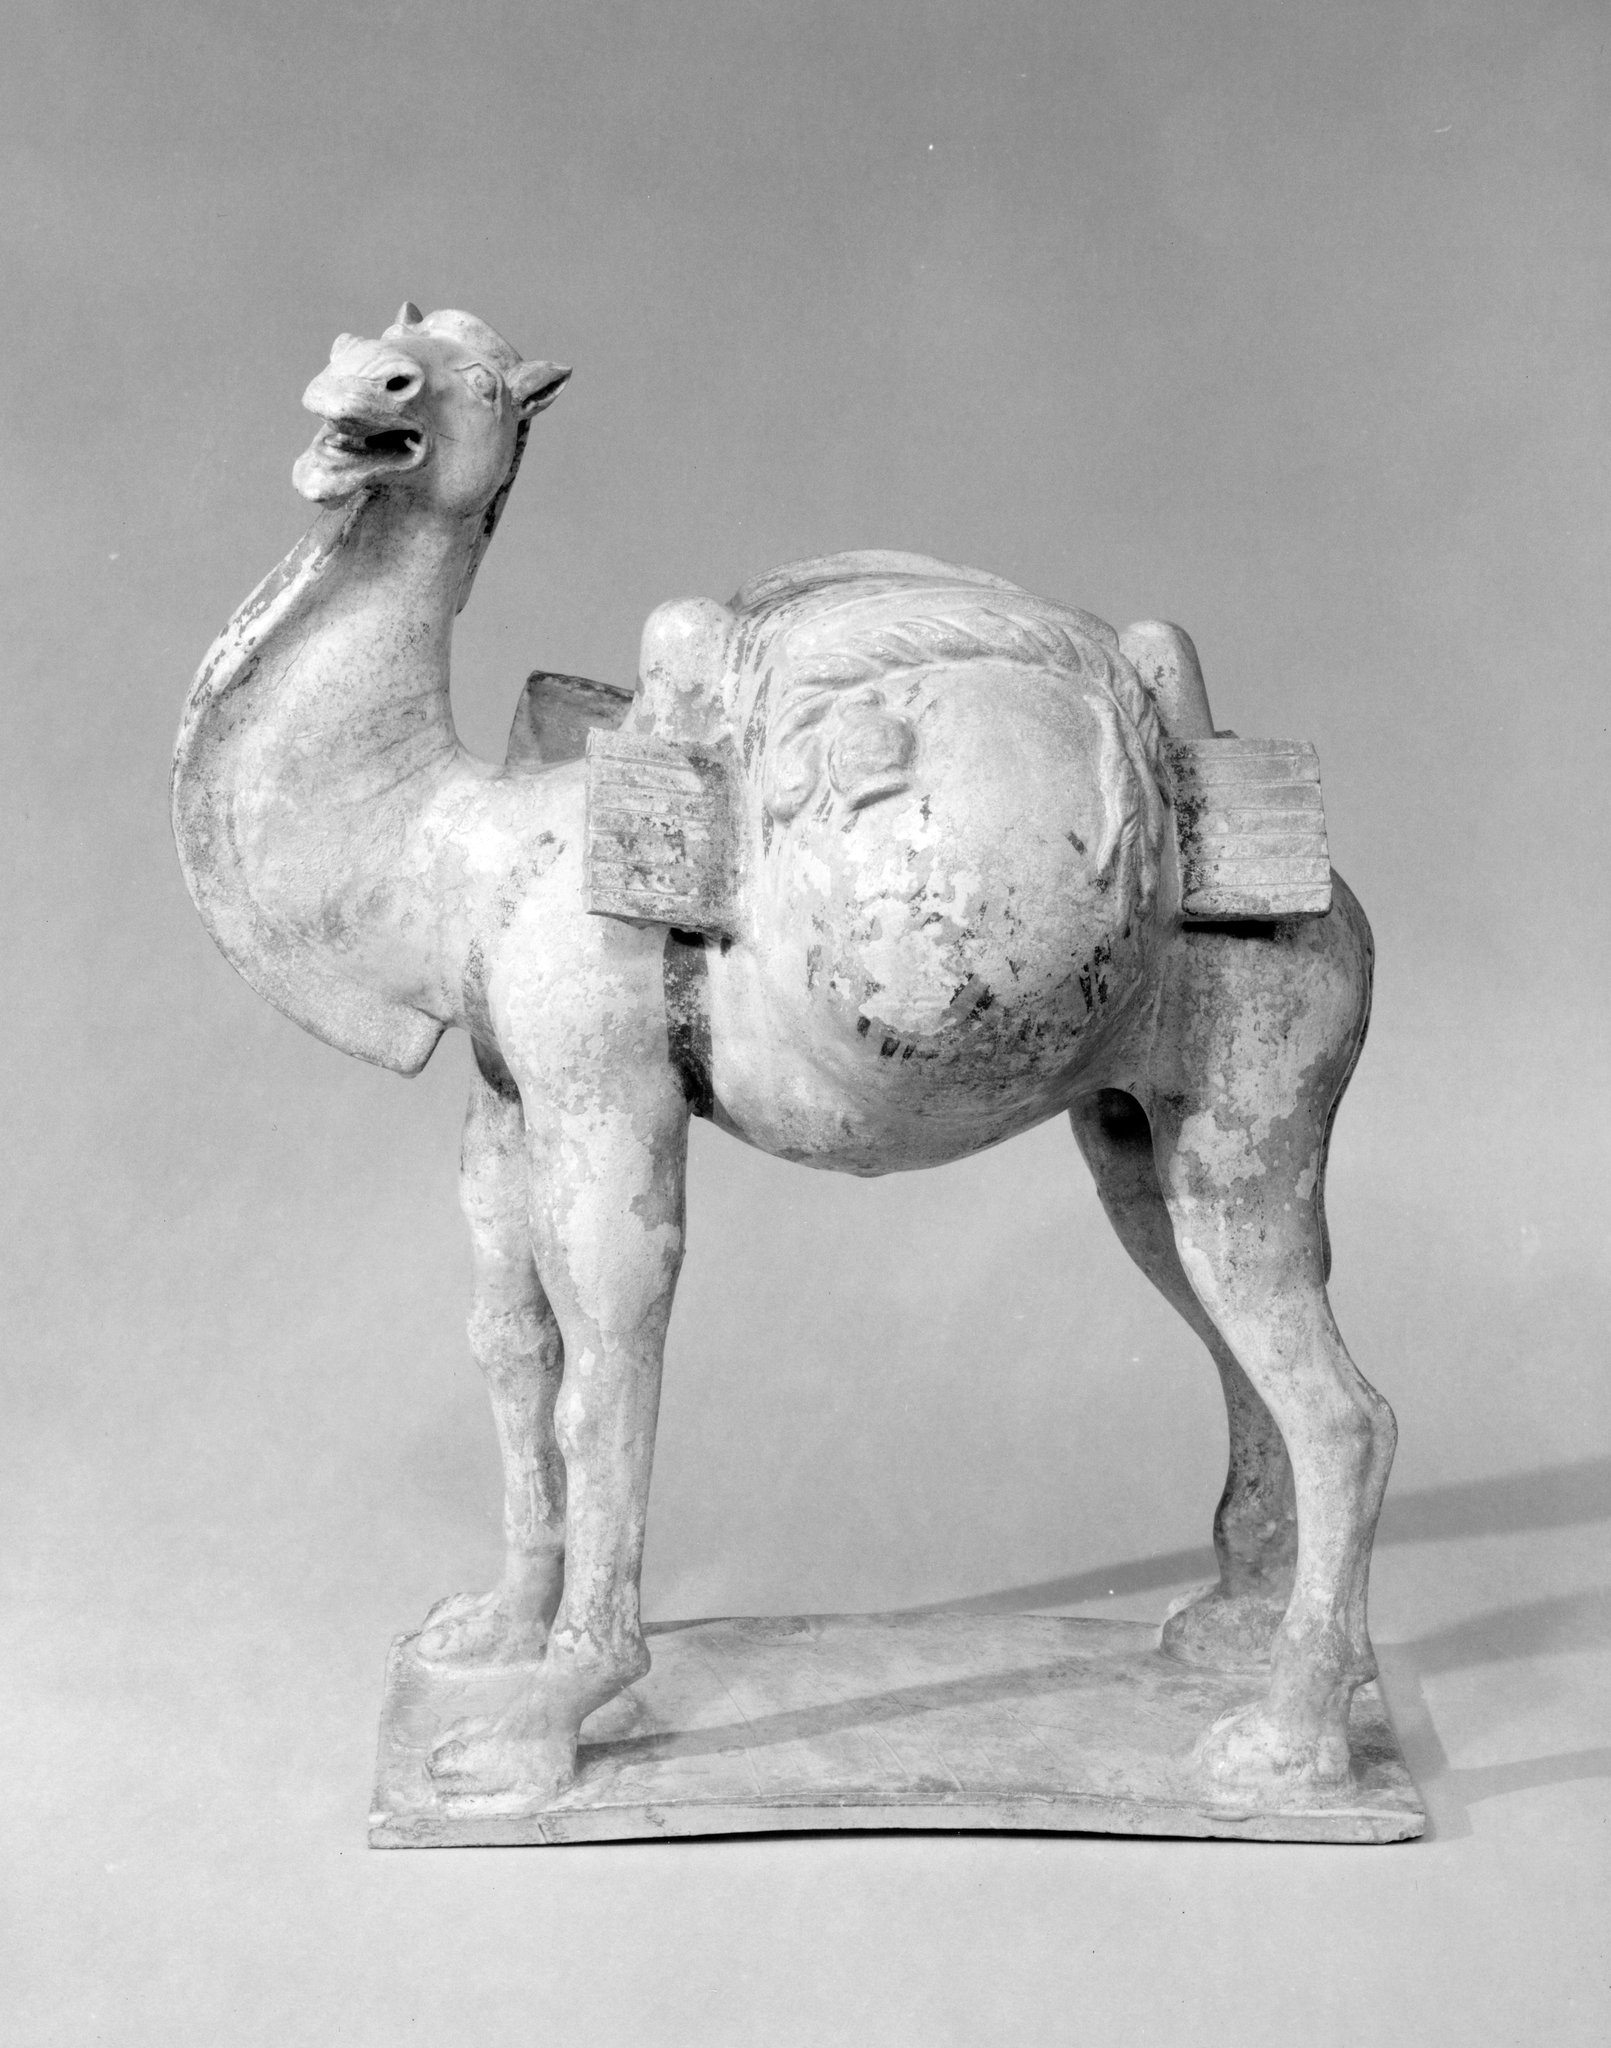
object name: figure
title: Camel with saddle bags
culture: chinese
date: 567-700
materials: earthenware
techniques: glazing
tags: camels